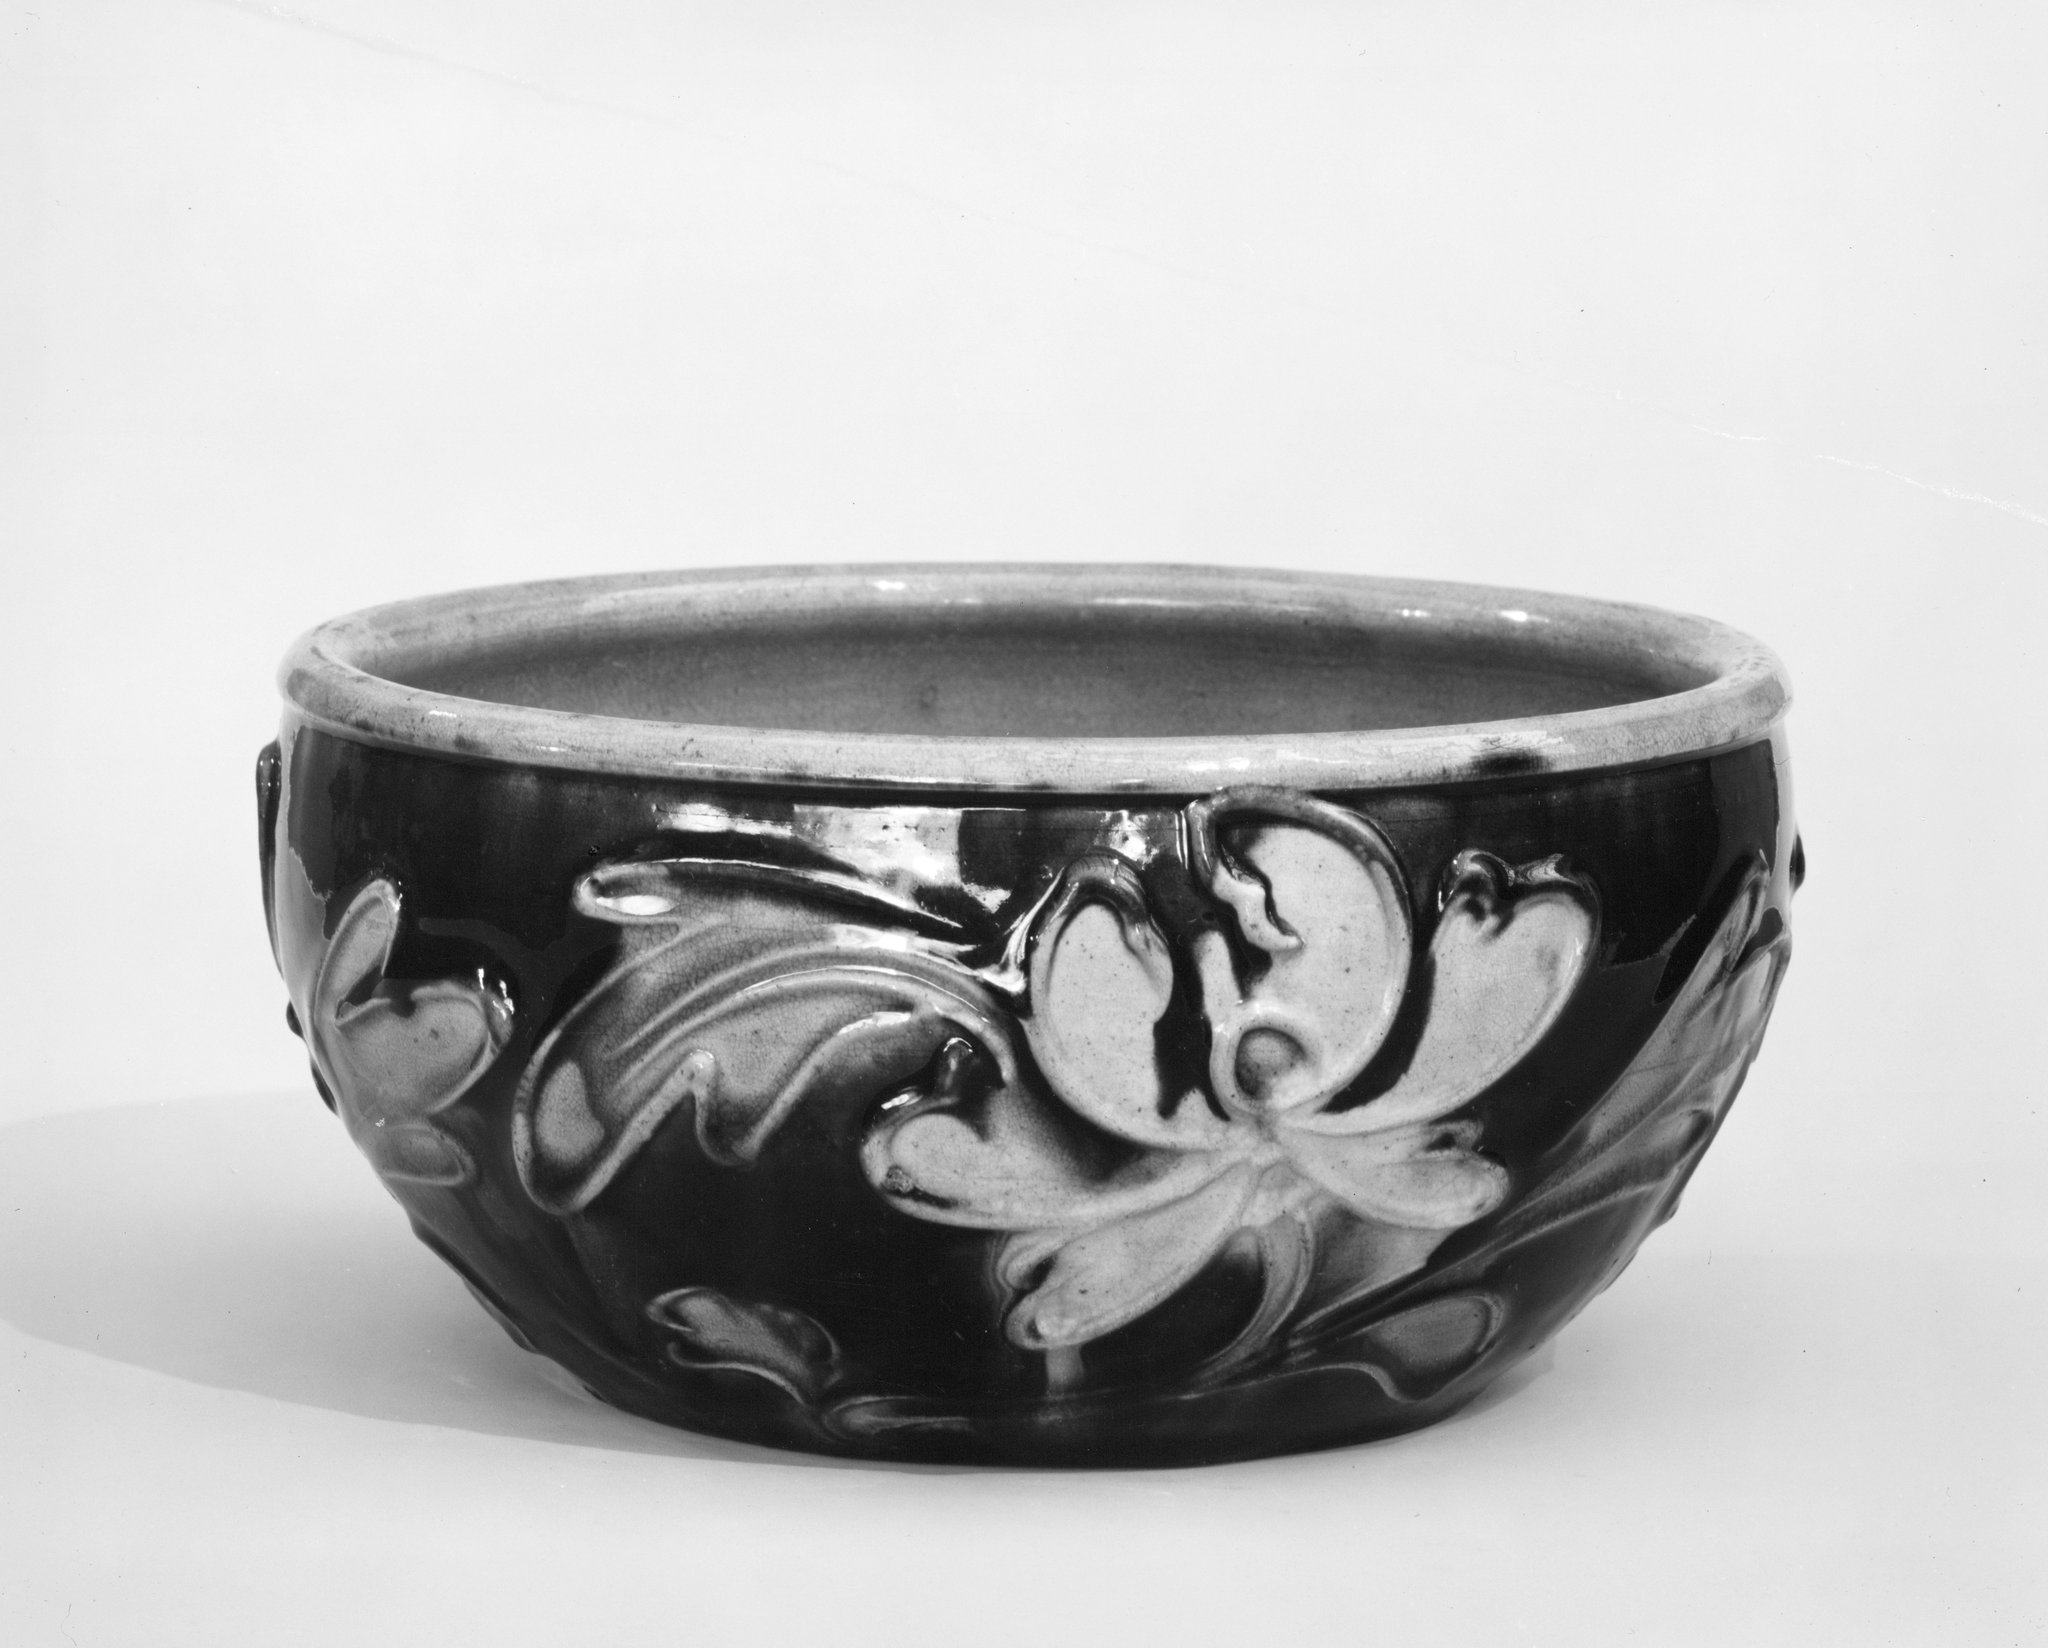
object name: bowl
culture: chinese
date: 1501-1600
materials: stoneware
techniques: enamel